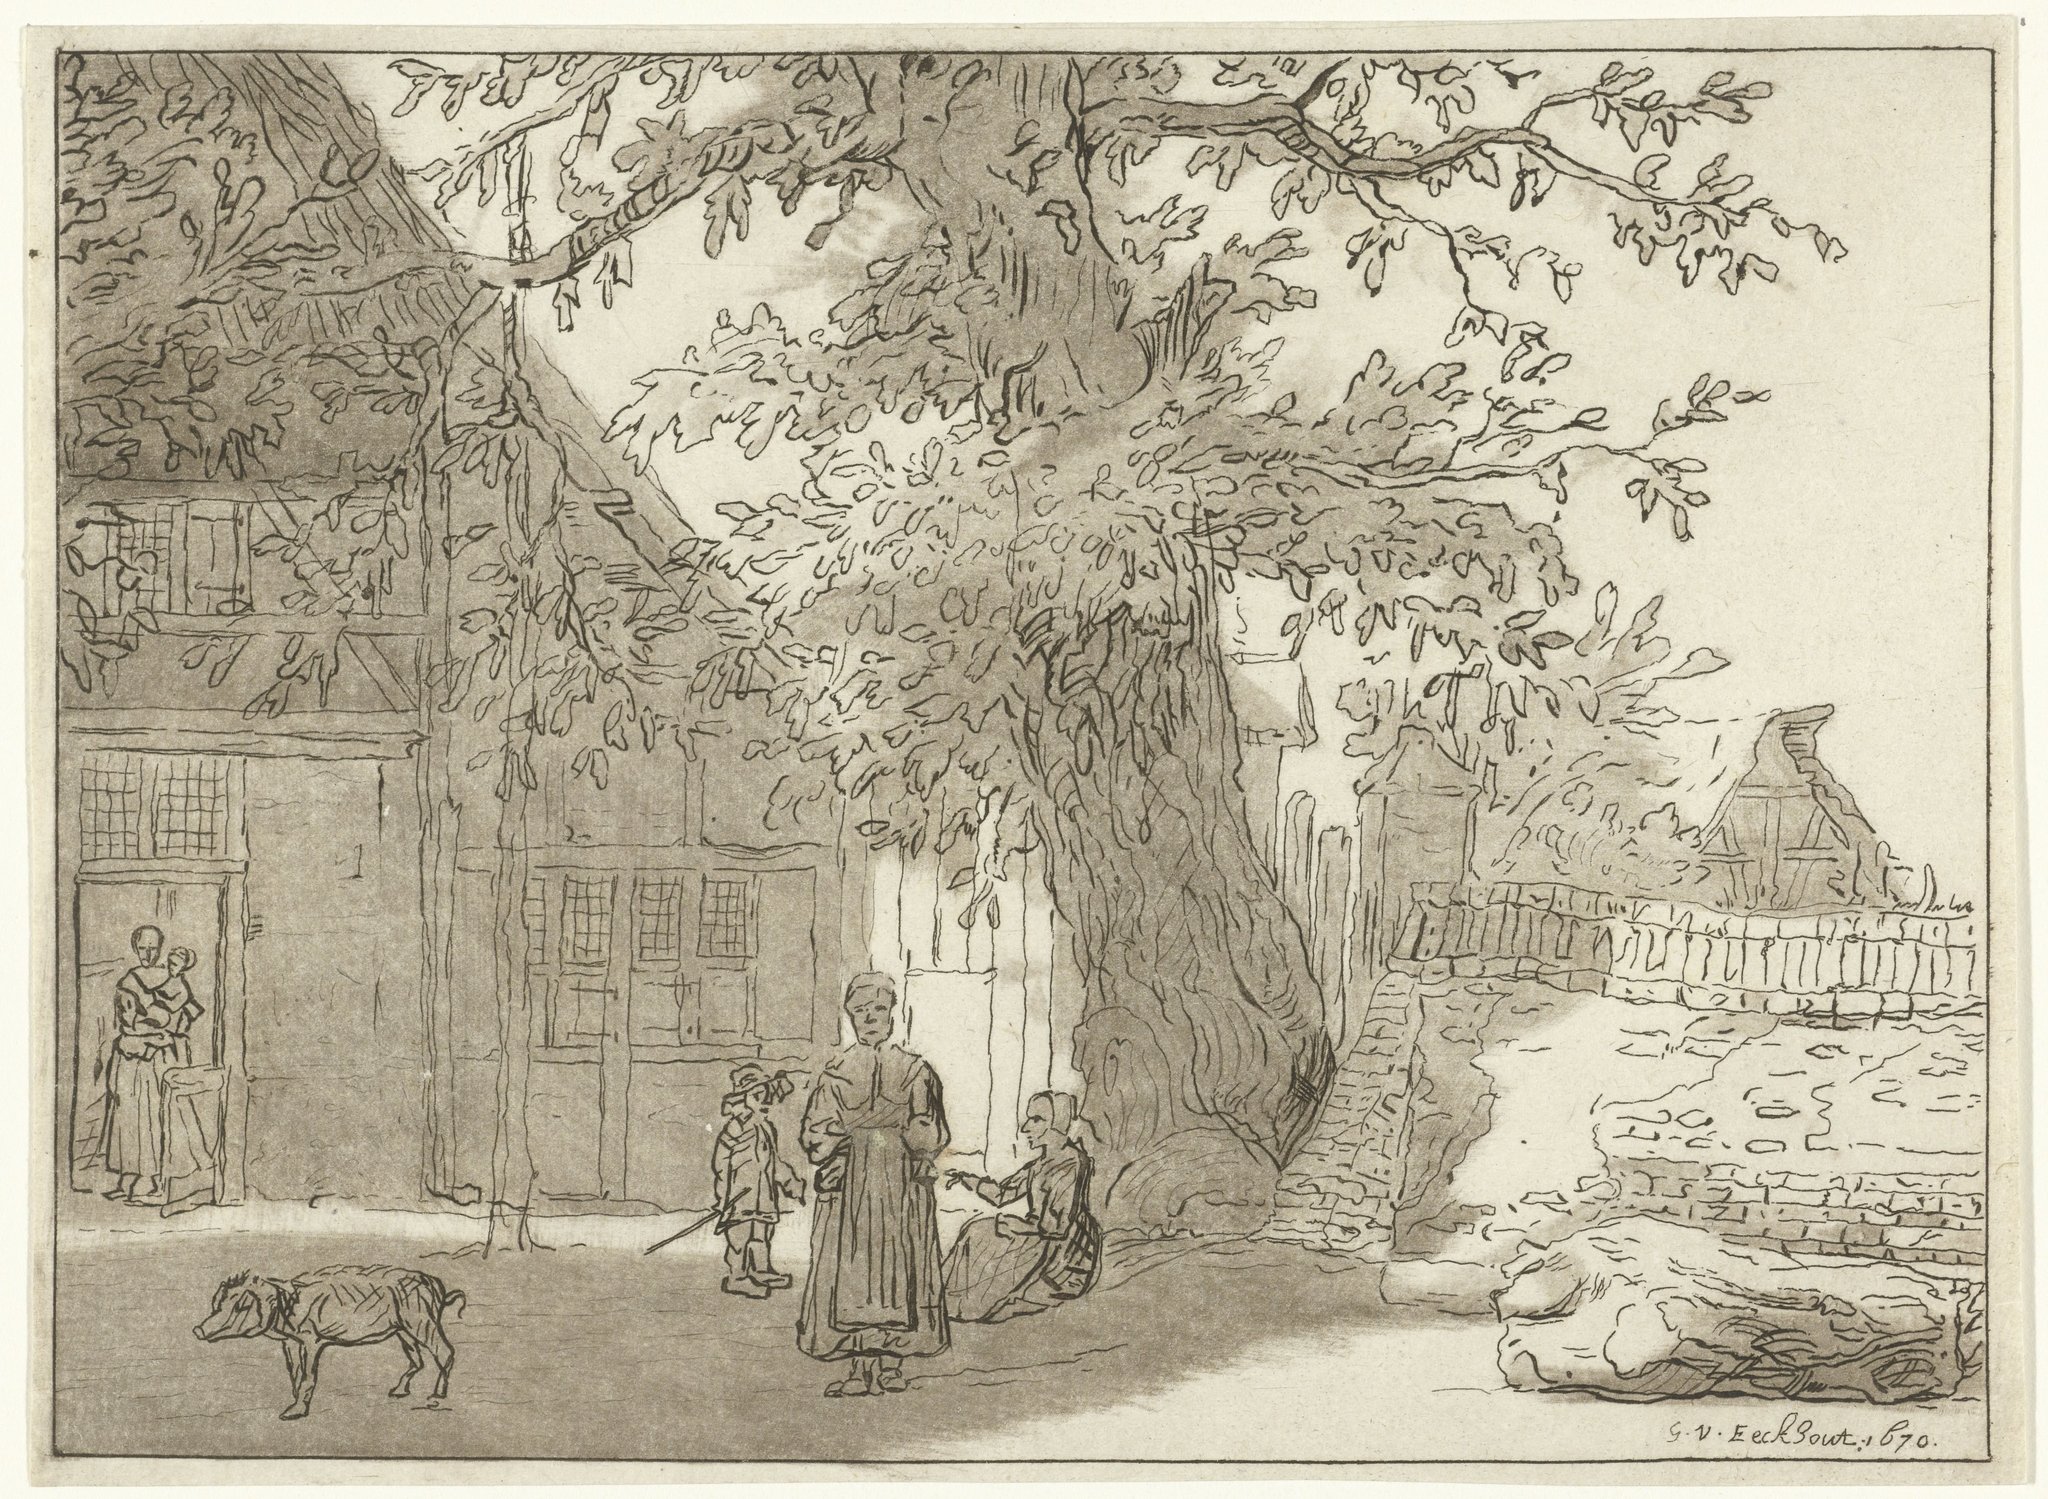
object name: print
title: Herberg te Anrath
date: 1759-1760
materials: paper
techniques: etching, roulette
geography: amsterdam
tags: trees, pig, village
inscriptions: collector's mark: Lugt 240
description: Herberg 'Zur blauen Hand am Kirchhof' te Anrath. In de deuropening een vrouw met kind op de arm. Naast de herberg een grote boom en enkele figuren daaronder. Links een varken.